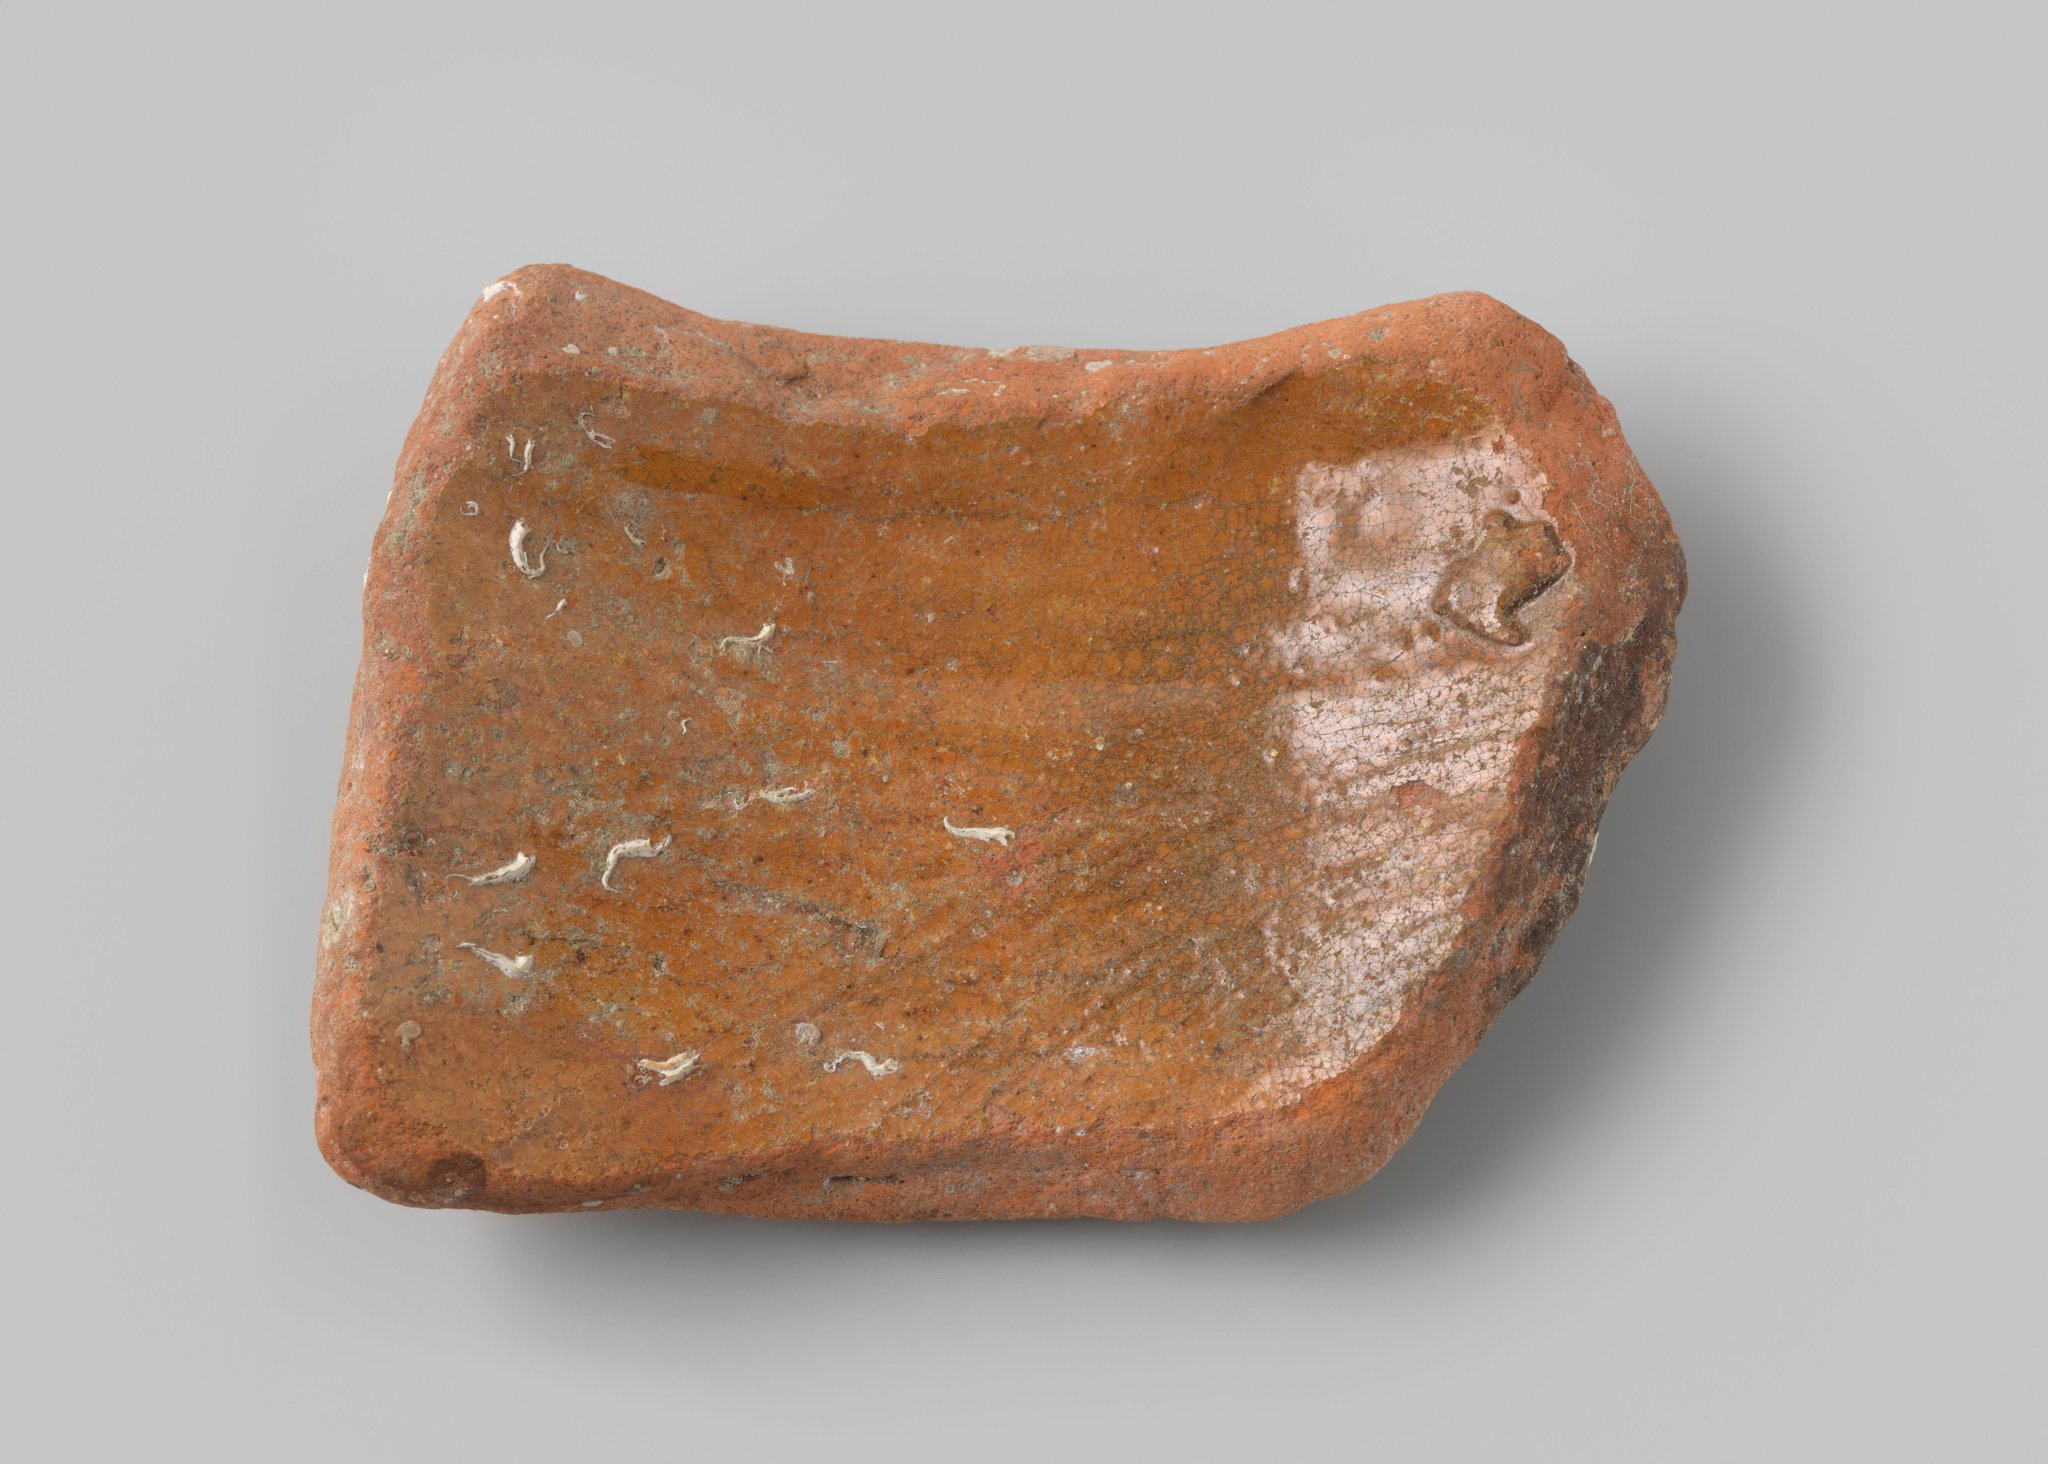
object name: sherd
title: Scherf van een pot of schaal uit het wrak van de Oost-Indiëvaarder Hollandia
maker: Anonymous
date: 1700-1743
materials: earthenware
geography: netherlands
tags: verenigde oostindische compagnie, hollandia (schip), annet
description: Earthenware (lead-glazed), pot or dish (hollow ware); fragm of wall, curved, both sides glazed, on convex side join of handle (vertical), eroded.